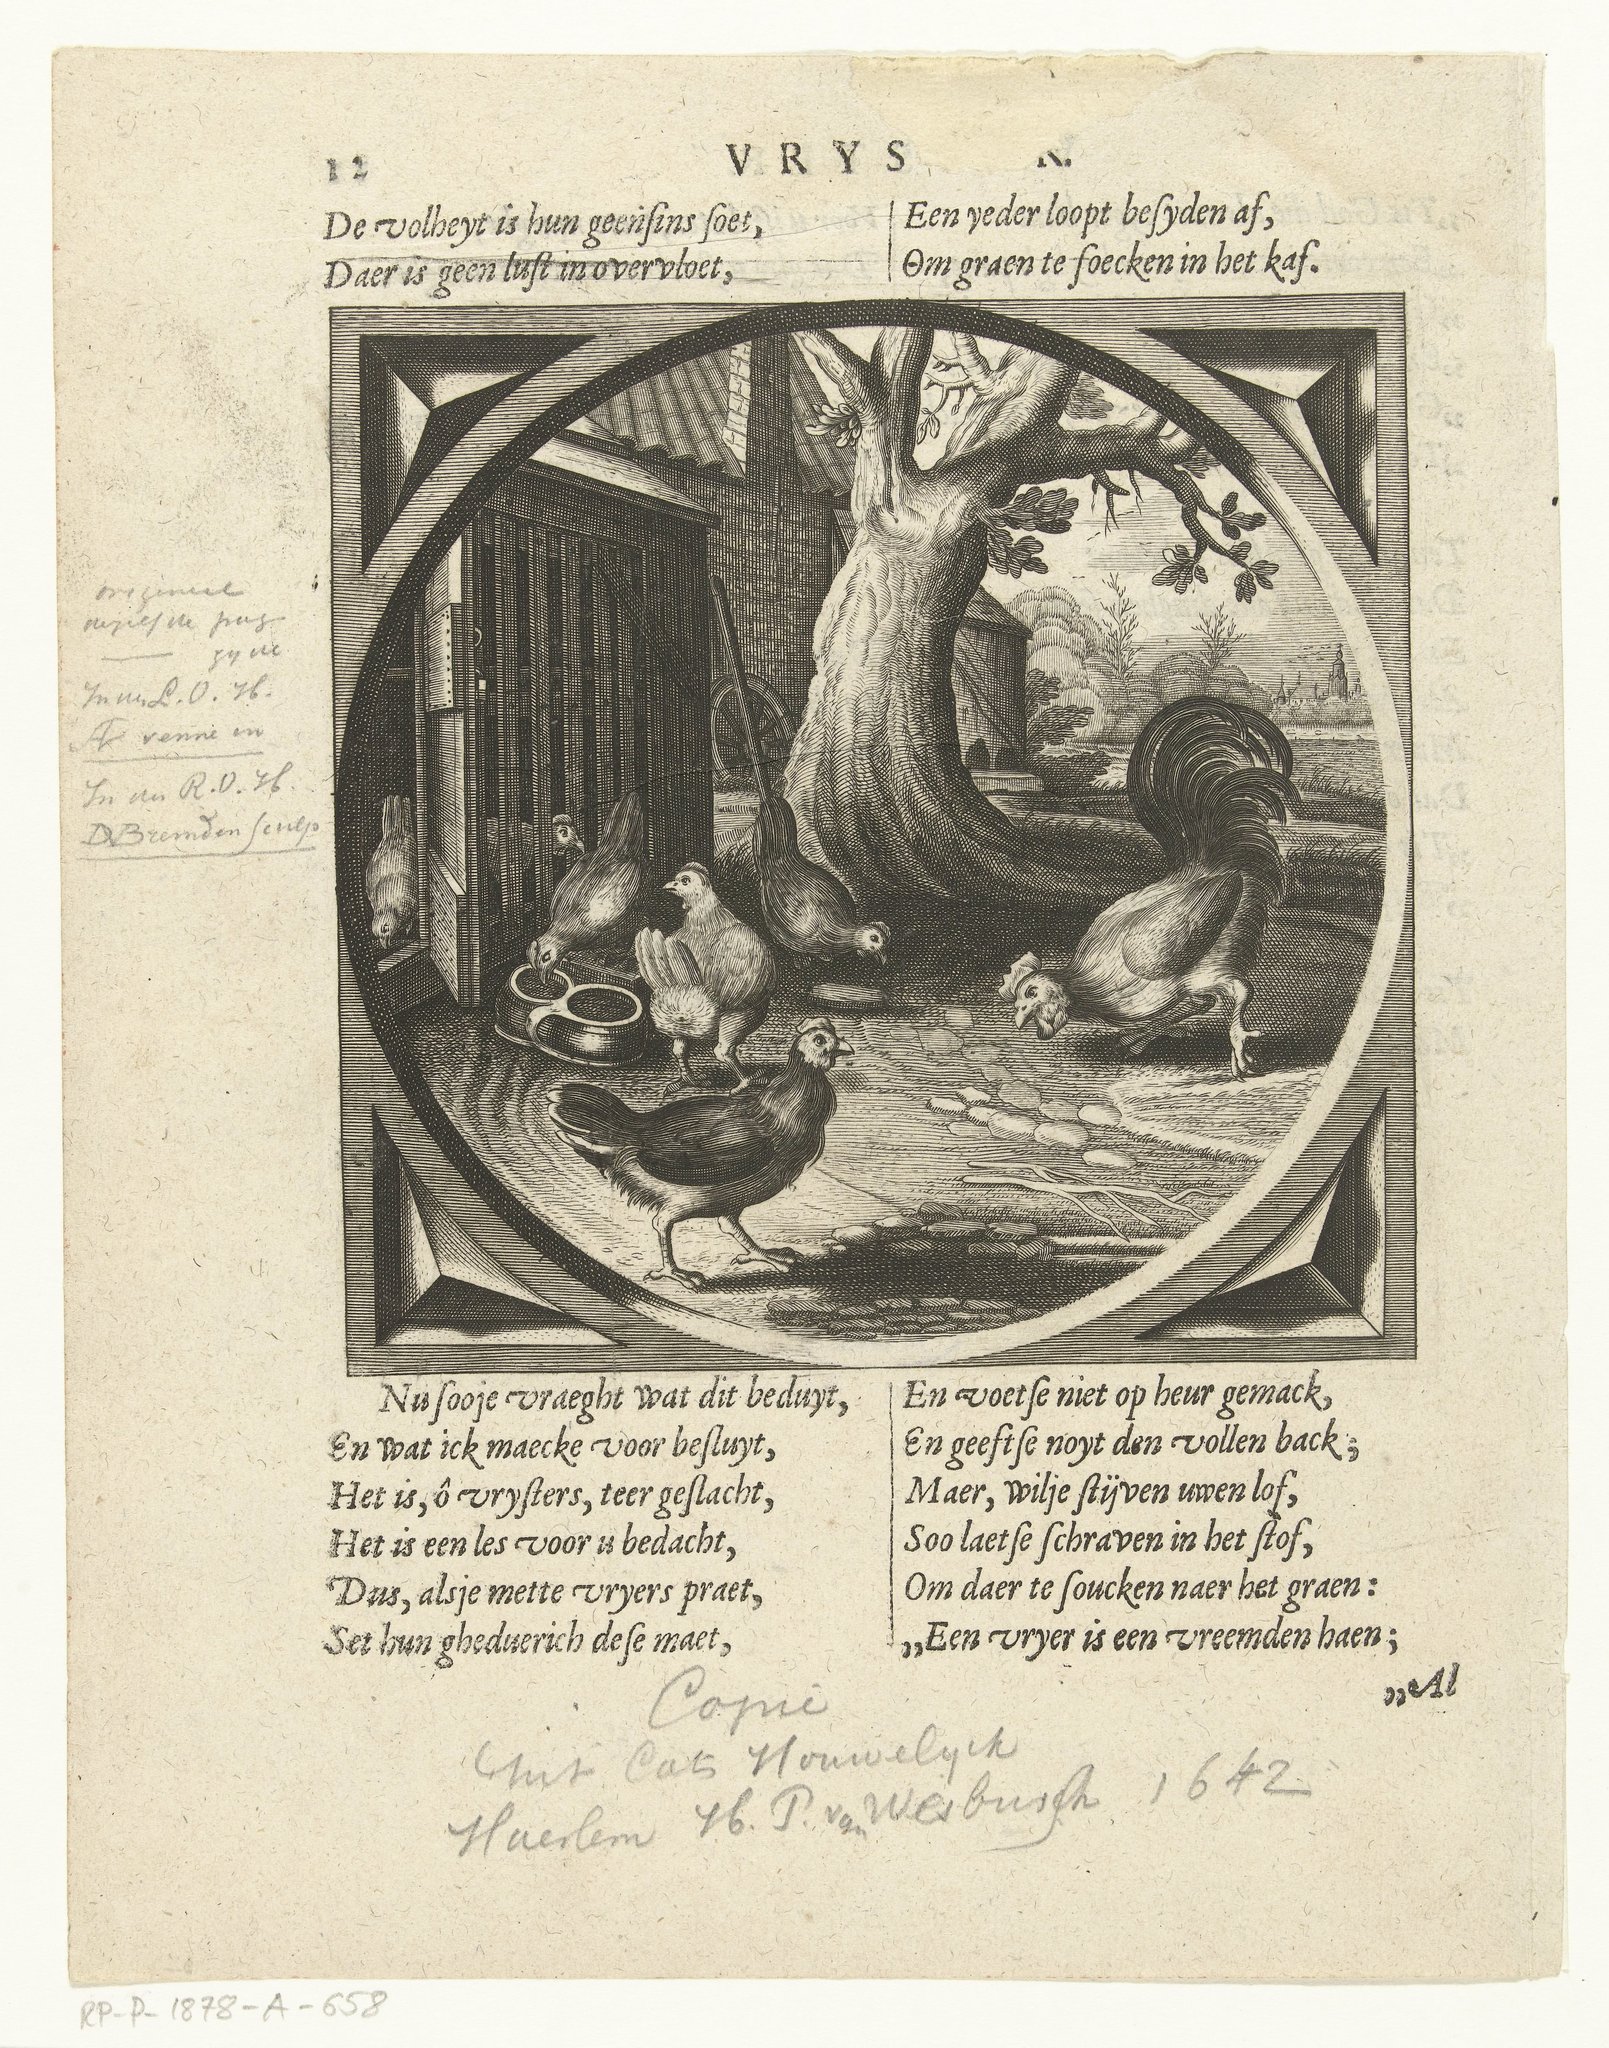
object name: print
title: Kippen en haan bij een kippenhok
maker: Anonymous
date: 1640-1650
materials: paper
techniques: engraving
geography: amsterdam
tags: fowl (cock, hen, chicken, etc.), chicken house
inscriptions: collector's mark: Lugt 2228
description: gebruikt voor: J. Cats, Hovwelyck, dat is: De gantsche gheleghentheydt des echten-staets. Haarlem: gedrukt bij Hans Passchiers van Wesbusch, Amsterdam: te koop bij Theunis Theunisz., 1642.